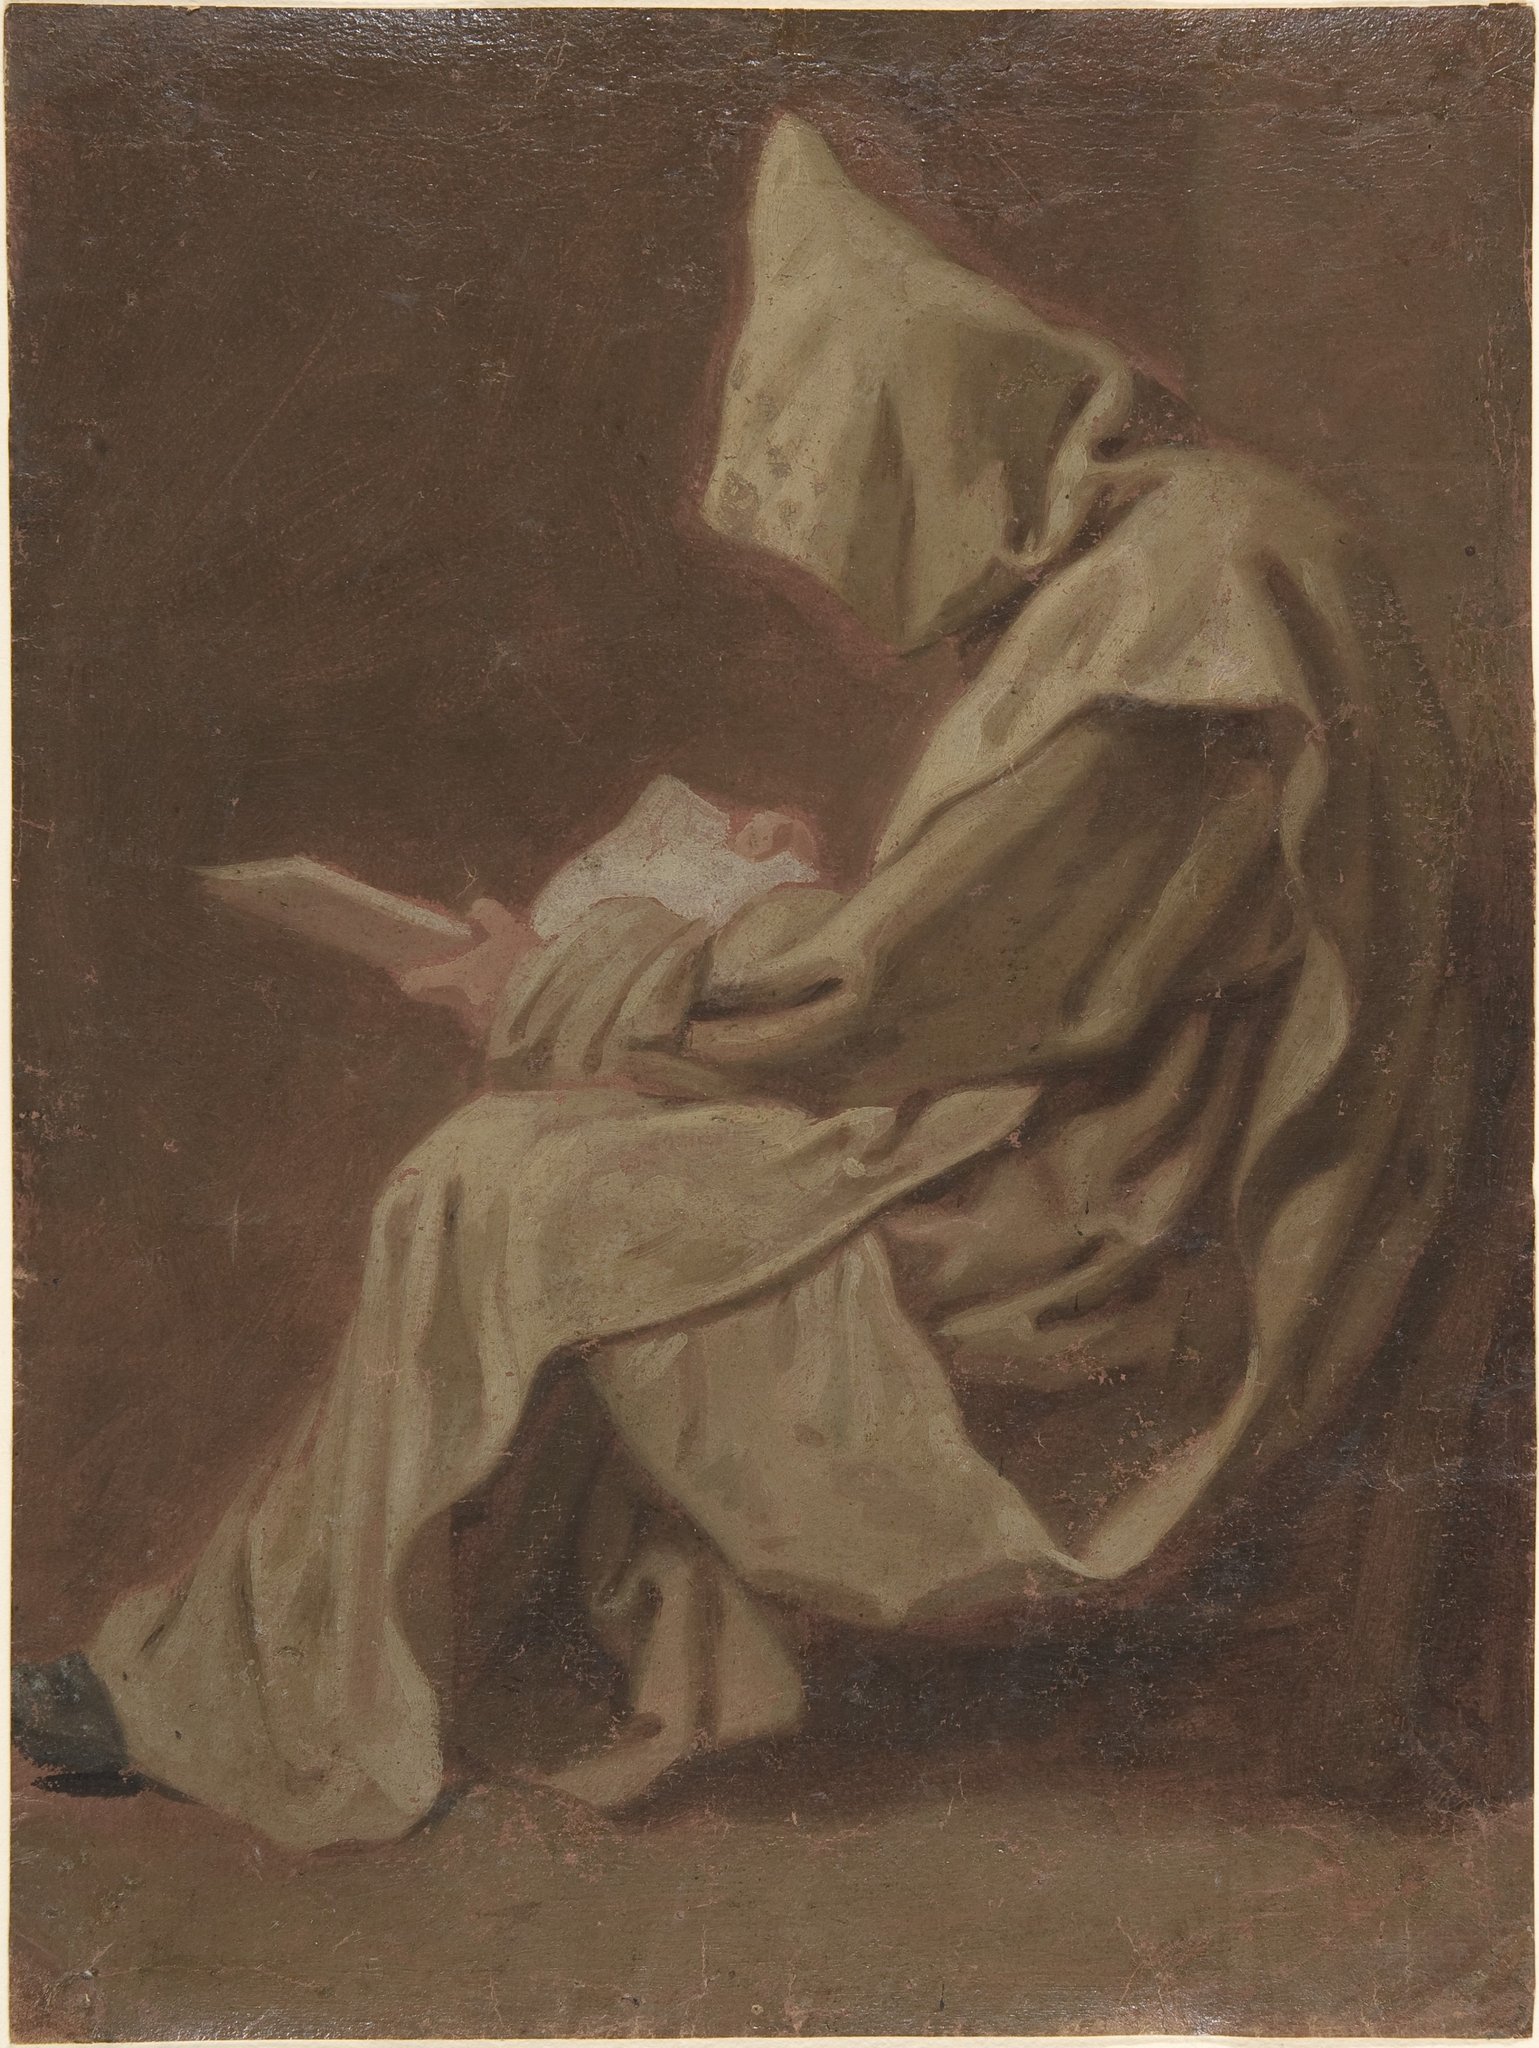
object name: drawing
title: Seated Carthusian Holding an Open Book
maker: jean restout le jeune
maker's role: artist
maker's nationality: french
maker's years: 1692-1768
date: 1711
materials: oil, paper, varnish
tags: books,reading,monks